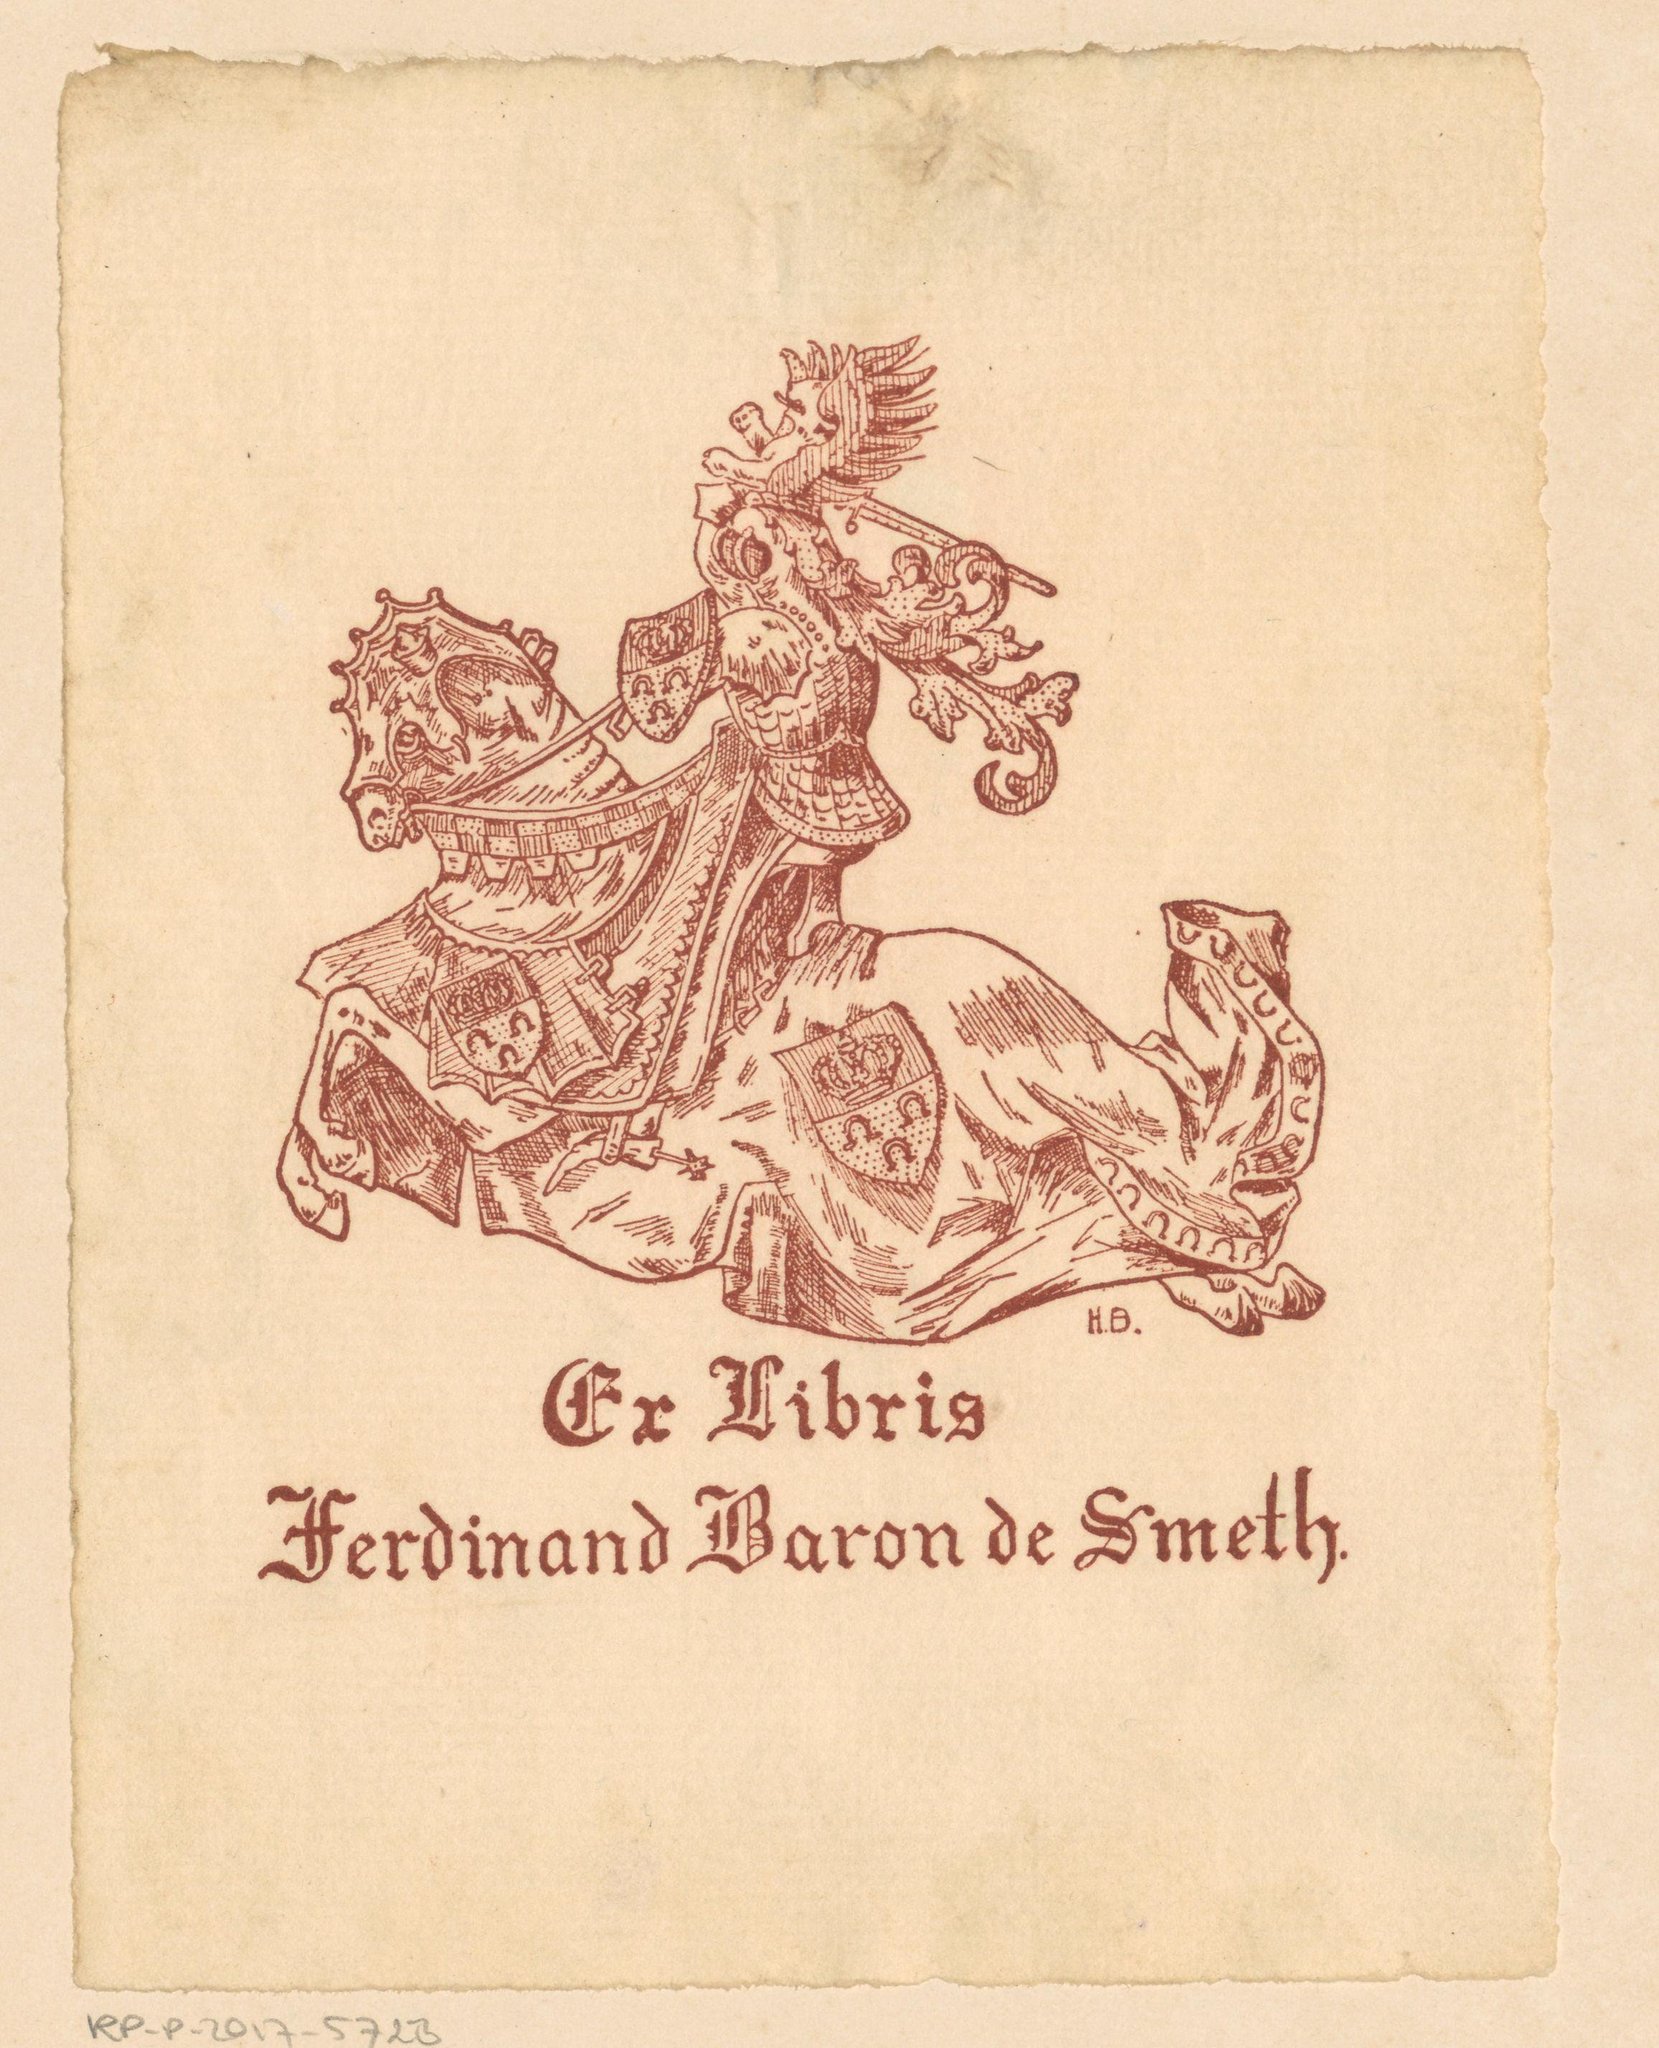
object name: bookplate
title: Ex libris van Ferdinand Baron de Smeth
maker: Anonymous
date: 1897-1924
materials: paper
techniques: lithograph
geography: netherlands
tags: the hague, horse, knight, armorial bearing, heraldry